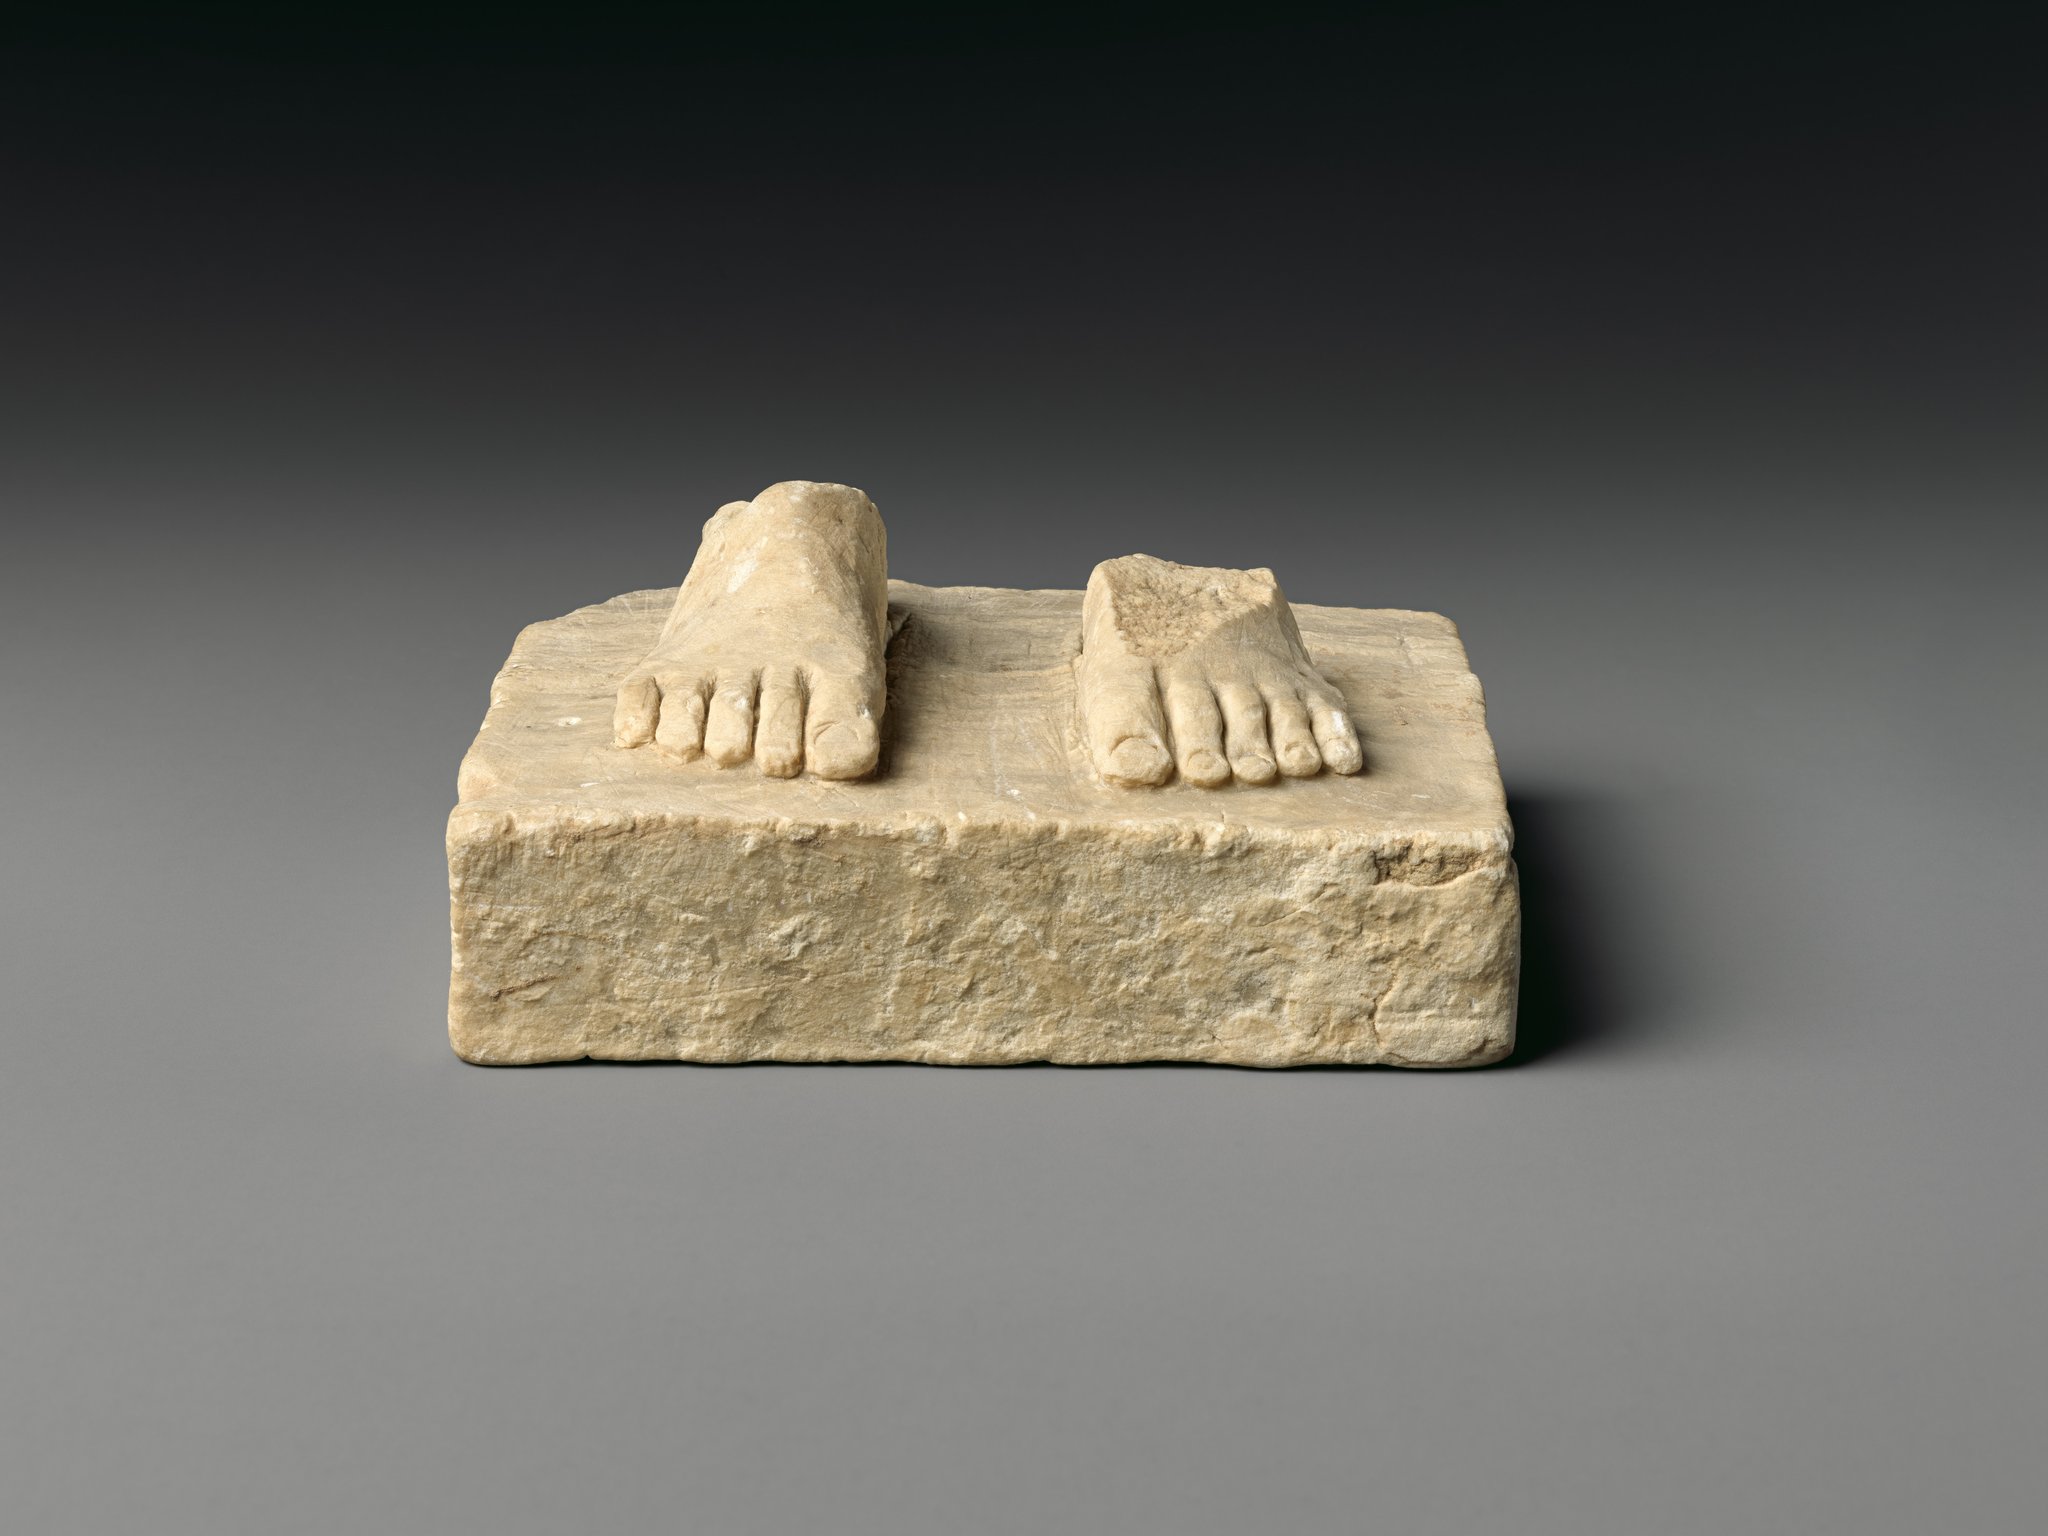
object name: sculpture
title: Base and feet of a worshipper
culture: sumerian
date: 2500-2350 BCE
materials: alabaster, gypsum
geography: mesopotamia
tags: feet